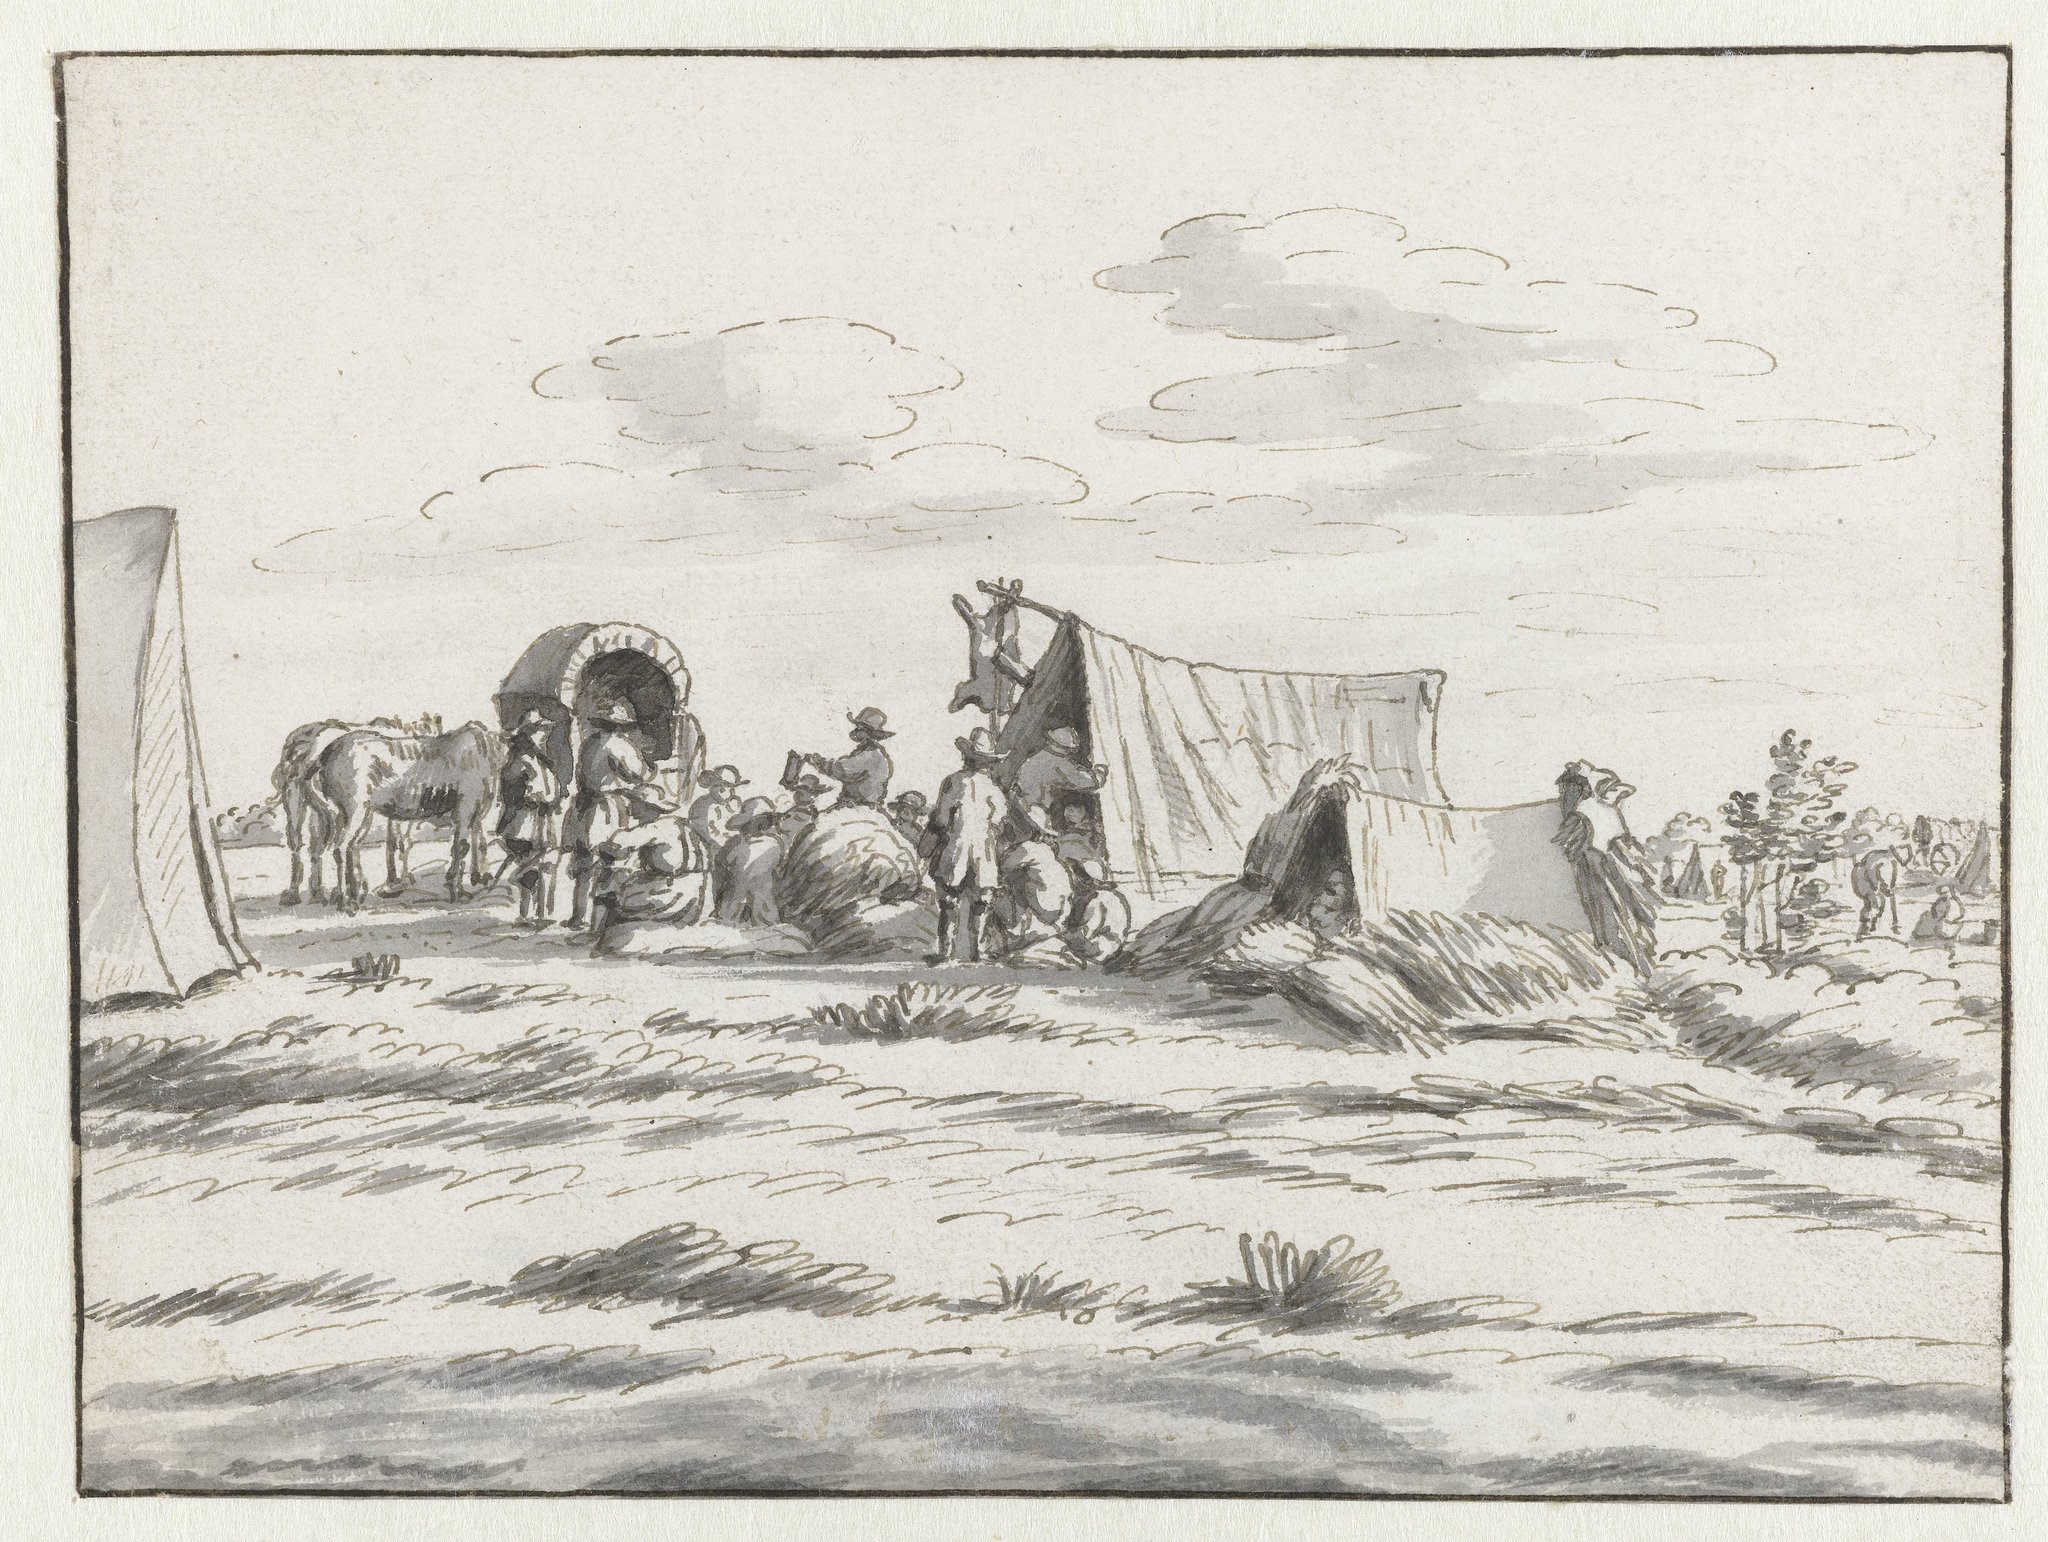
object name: drawing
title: View of an Encampment of the Army of Willem III near Leuven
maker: josua de grave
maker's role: draughtsman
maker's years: 1645-1712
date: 1675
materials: ink, paper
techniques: brush, pen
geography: leuven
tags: william iii (prince of orange and king of england, scotland, and ireland), (military) camp with tents, louvain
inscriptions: date: ‘16 7/13 75’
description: Kampement van het leger van Willem III bij Leuven, 13 juli 1675. Soldaten en tenten.